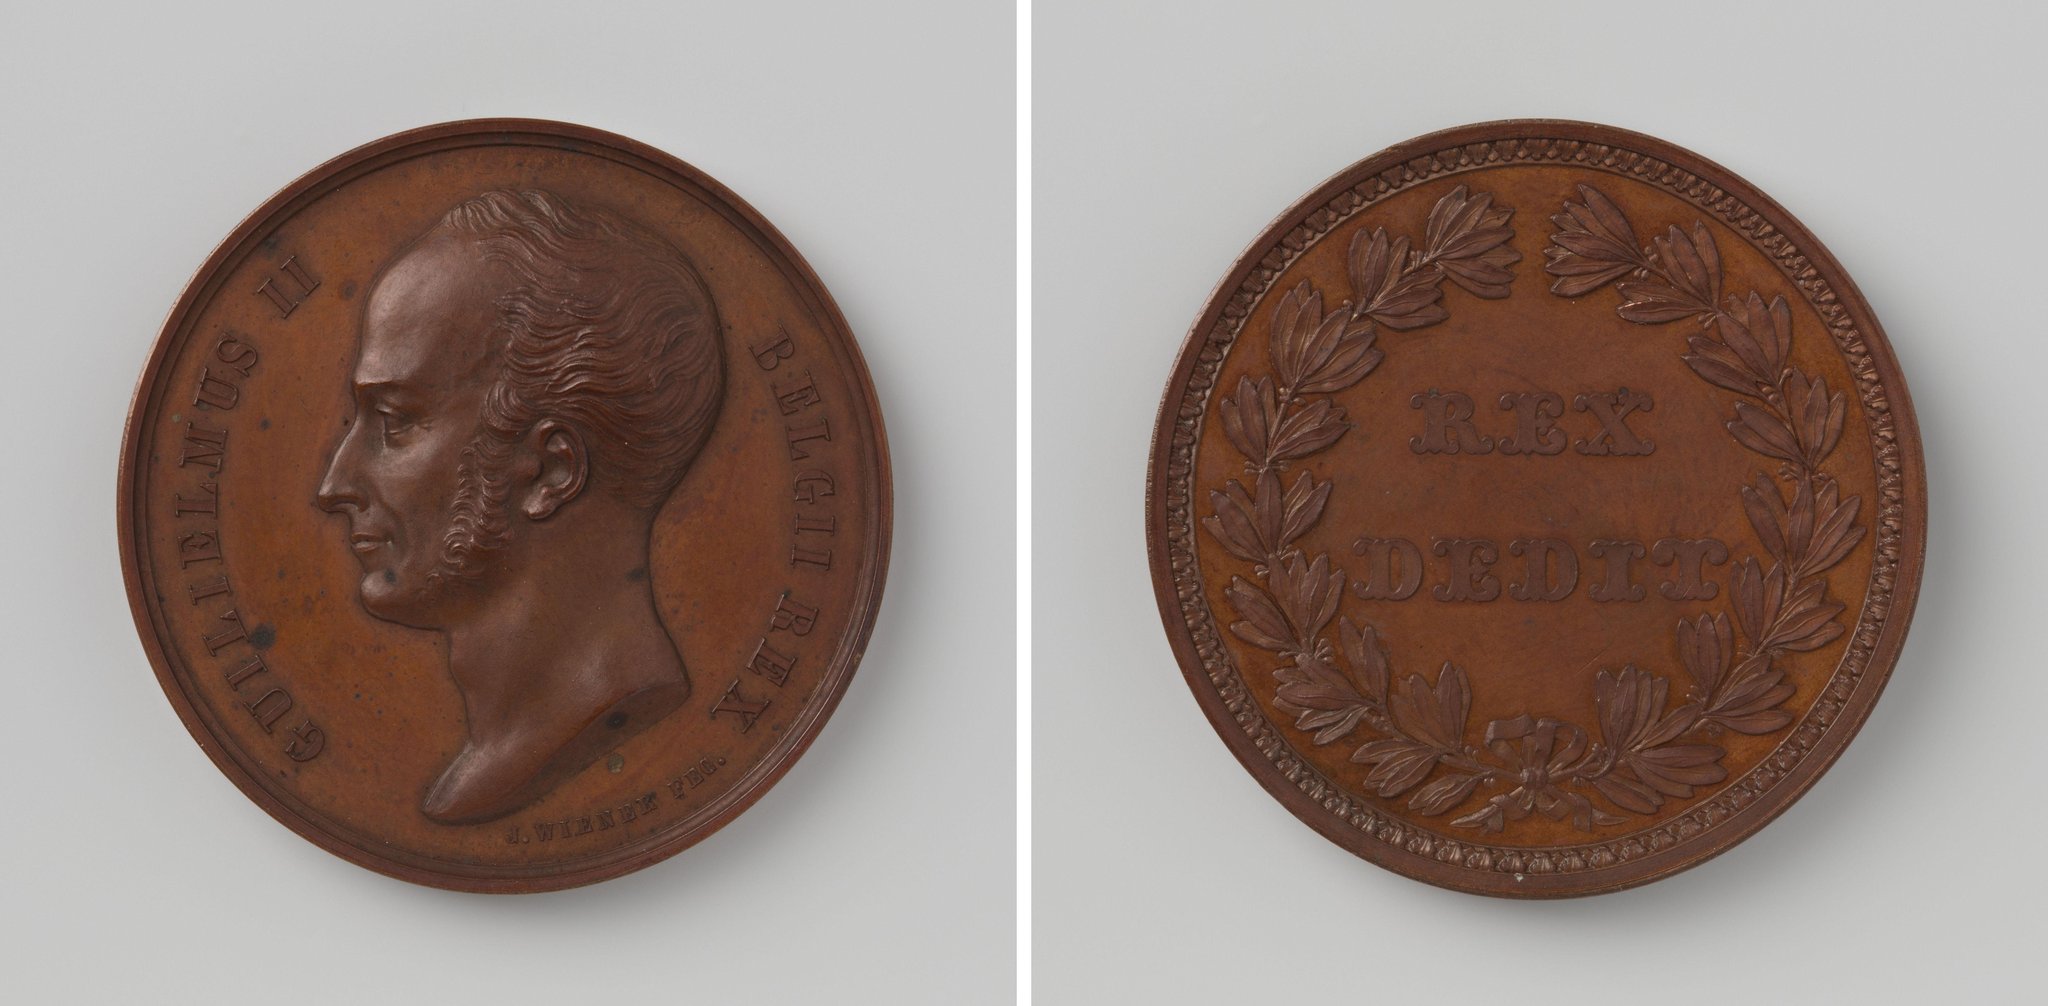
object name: history medal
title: Instelling van de Luxemburgse Orde van de Eikenkroon, ter ere van Willem II, koning der Nederlanden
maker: jacob wiener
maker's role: medailleur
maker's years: 1815-1899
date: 1841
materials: bronze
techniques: striking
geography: brussels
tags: the hague, william ii of the netherlands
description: Bronzen penning. Voorzijde: borststuk man binnen omschrift. Keerzijde: opschrift binnen krans van myrte-loof en sierrand.